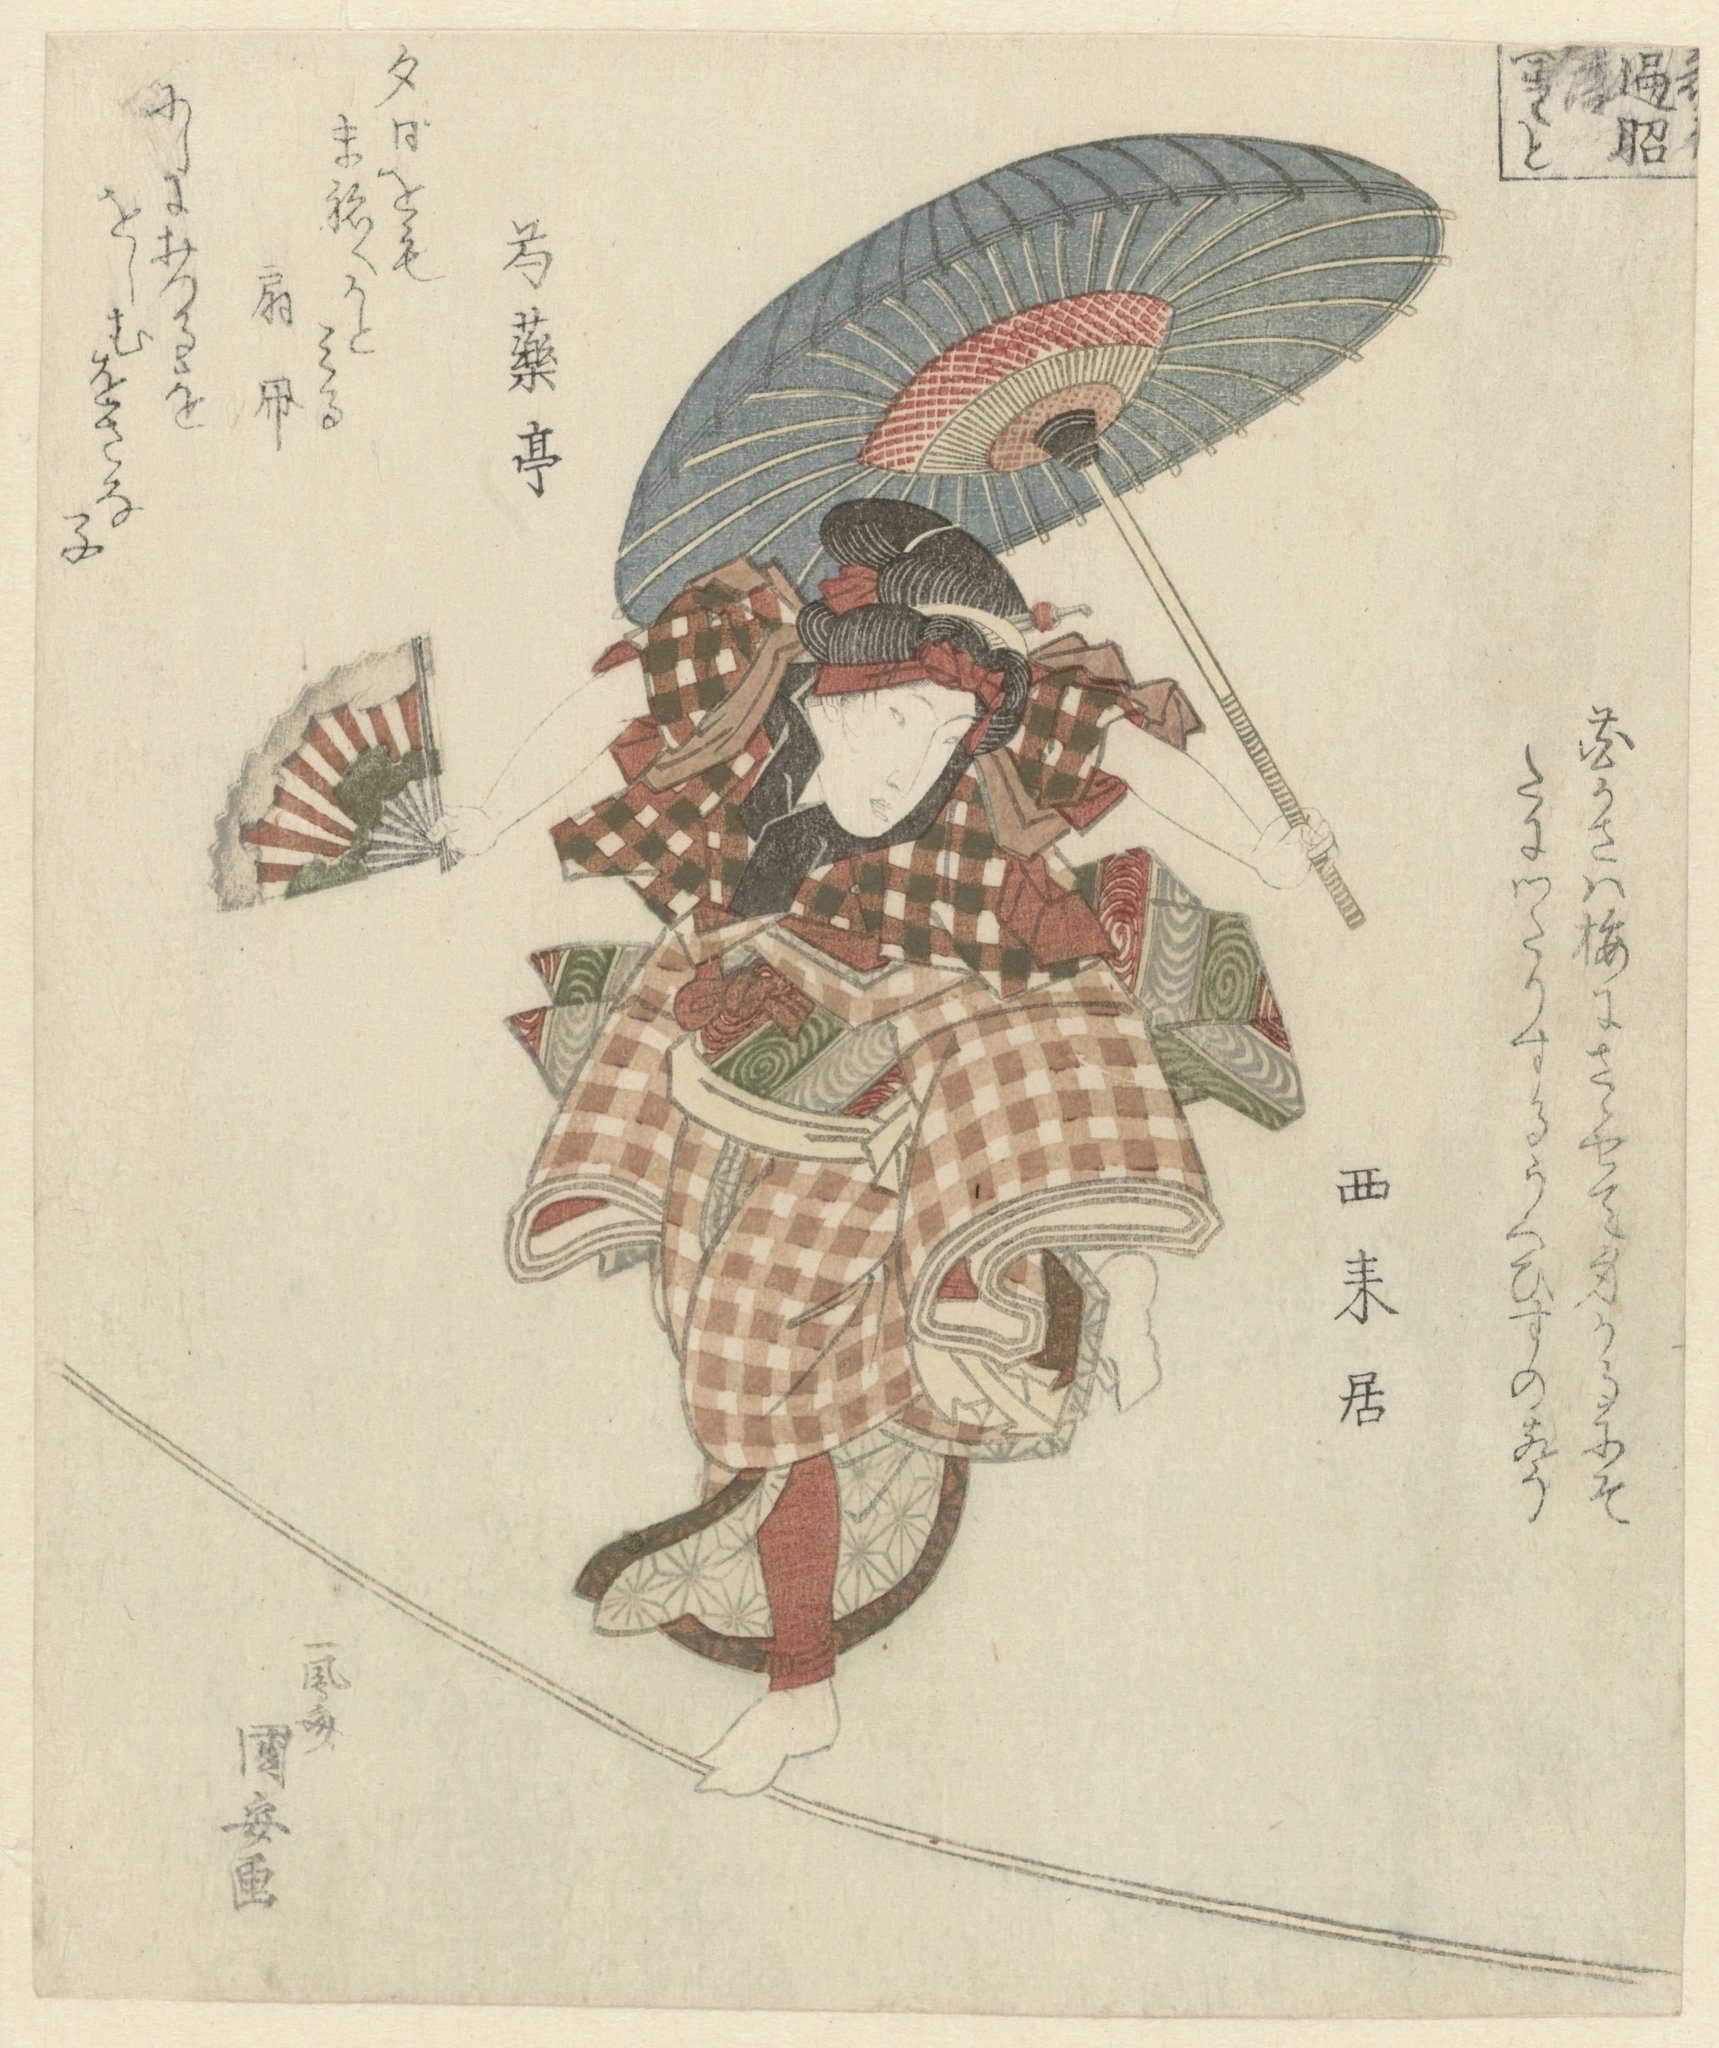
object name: surimono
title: A Woman Walking on a Rope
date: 1830-1835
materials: paper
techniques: woodcut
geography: japan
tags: tight-ropewalker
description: Een surimono is een luxe uitgevoerde prent waarop beeld met één of meerdere gedichten gecombineerd is. Bij het drukken van een surimono werd vaak gebruik gemaakt van dikker papier, blinddruk en metaal pigmenten, zoals koper- en zilverpoeder. De prenten werden vaak in opdracht van dichters gemaakt en als exclusief geschenk aan vrienden en relaties gegeven.